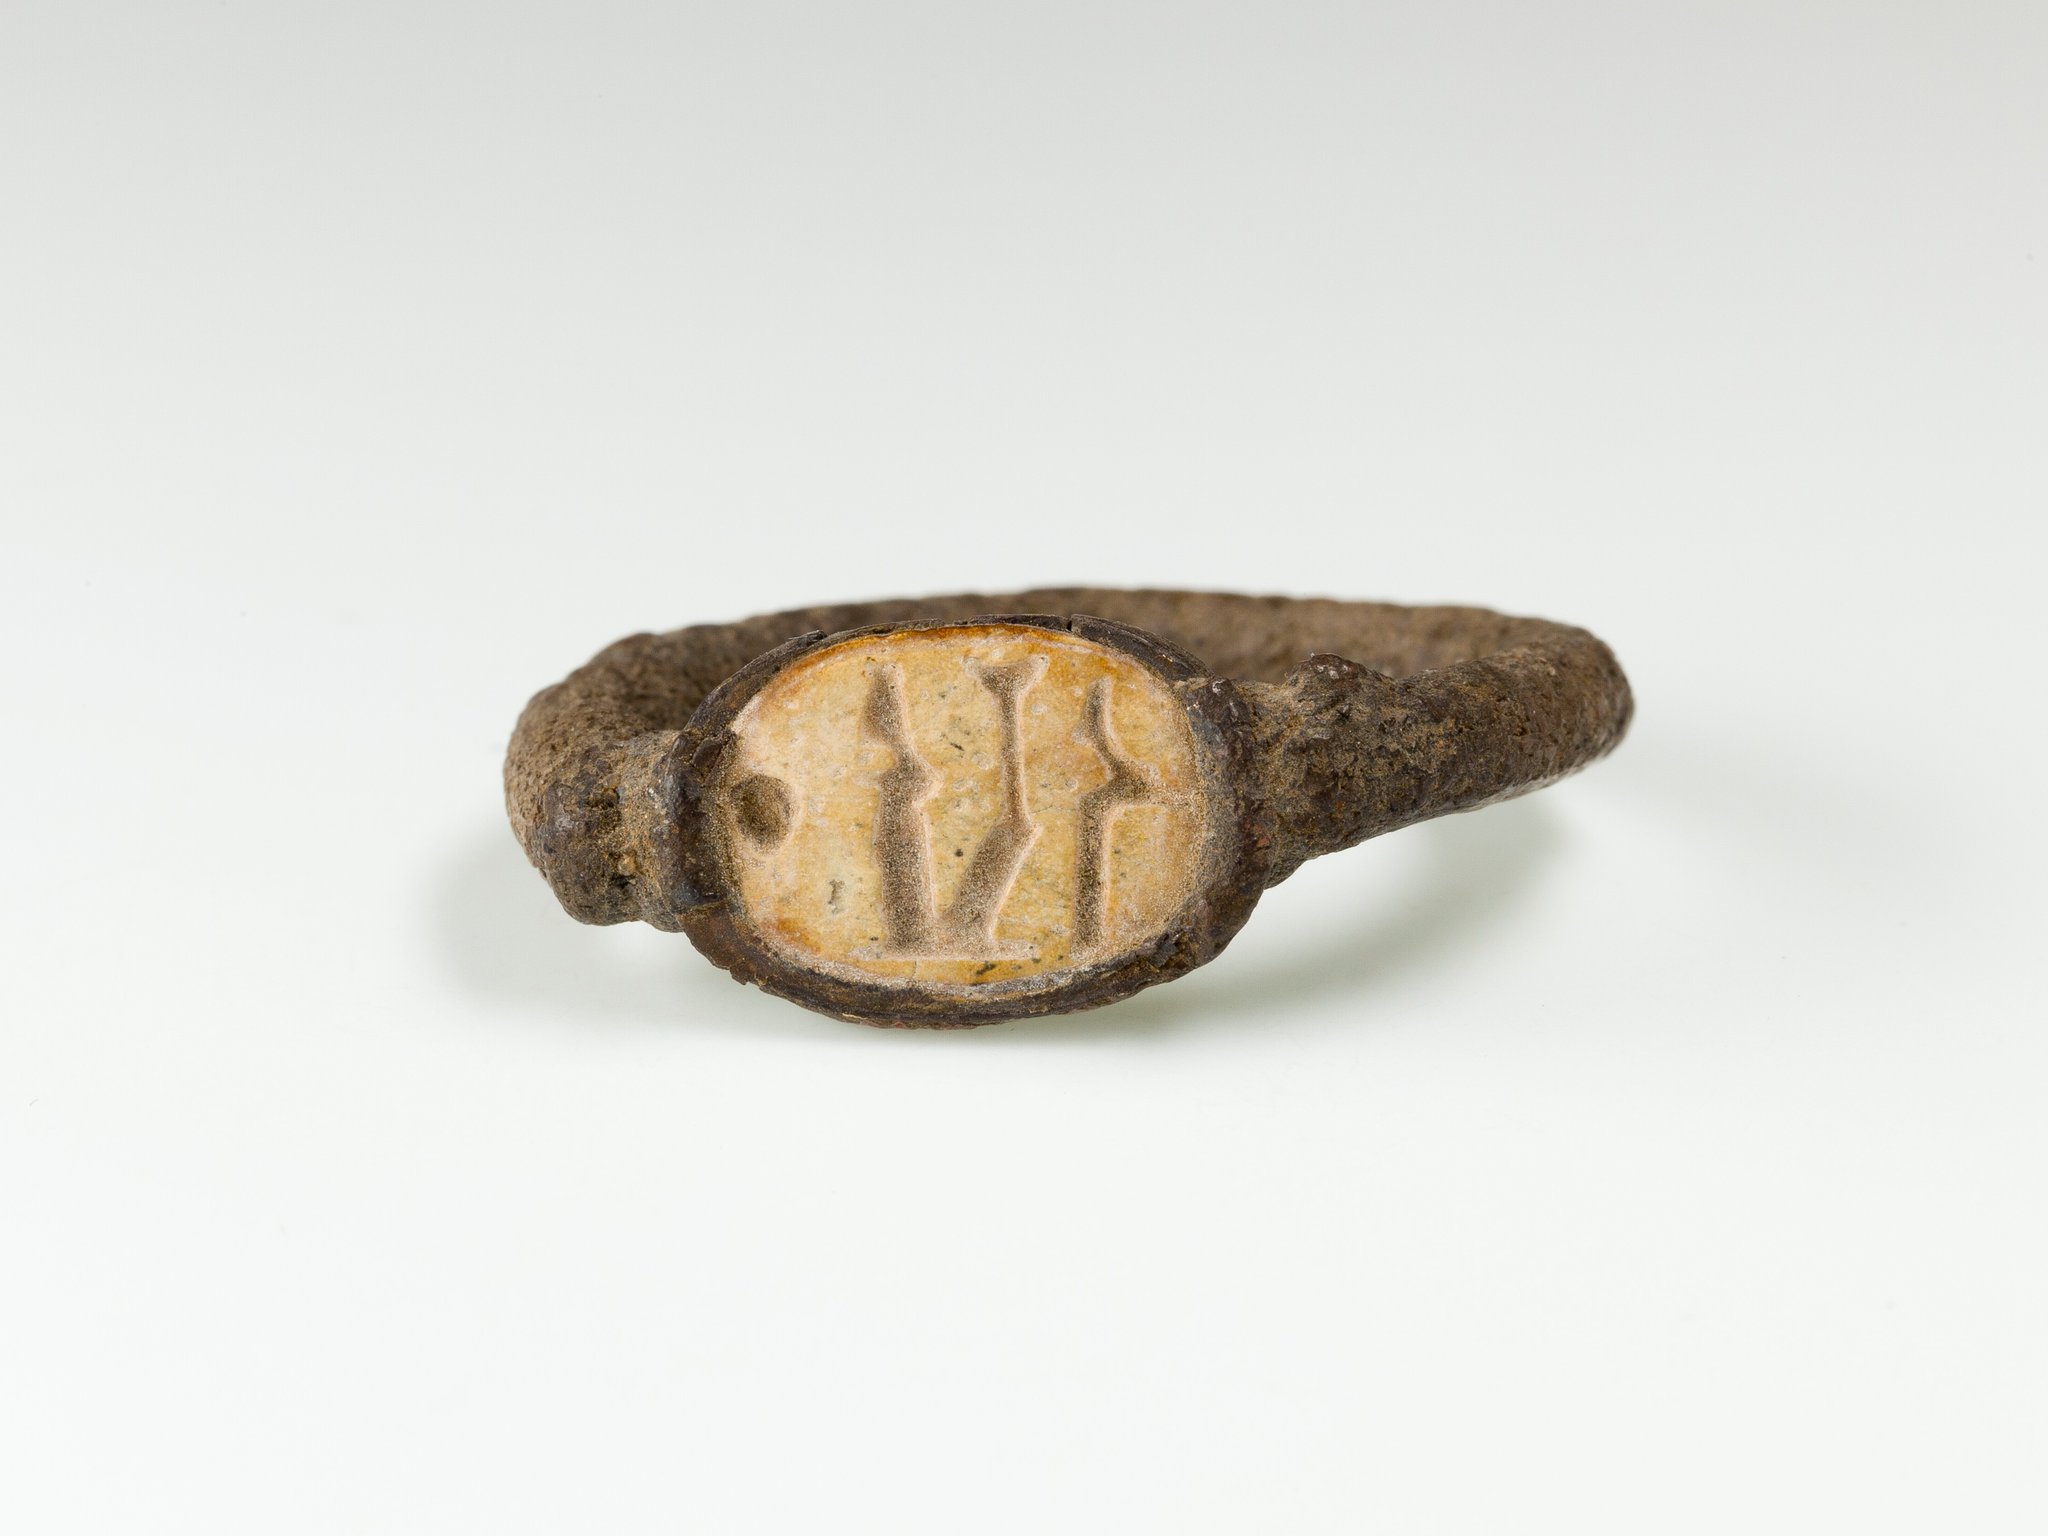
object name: ring, scarab, ramesses ii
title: Scarab Finger Ring of Ramesses II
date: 1295-1070 BCE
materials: silver, stone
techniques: glazing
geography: egypt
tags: scarabs